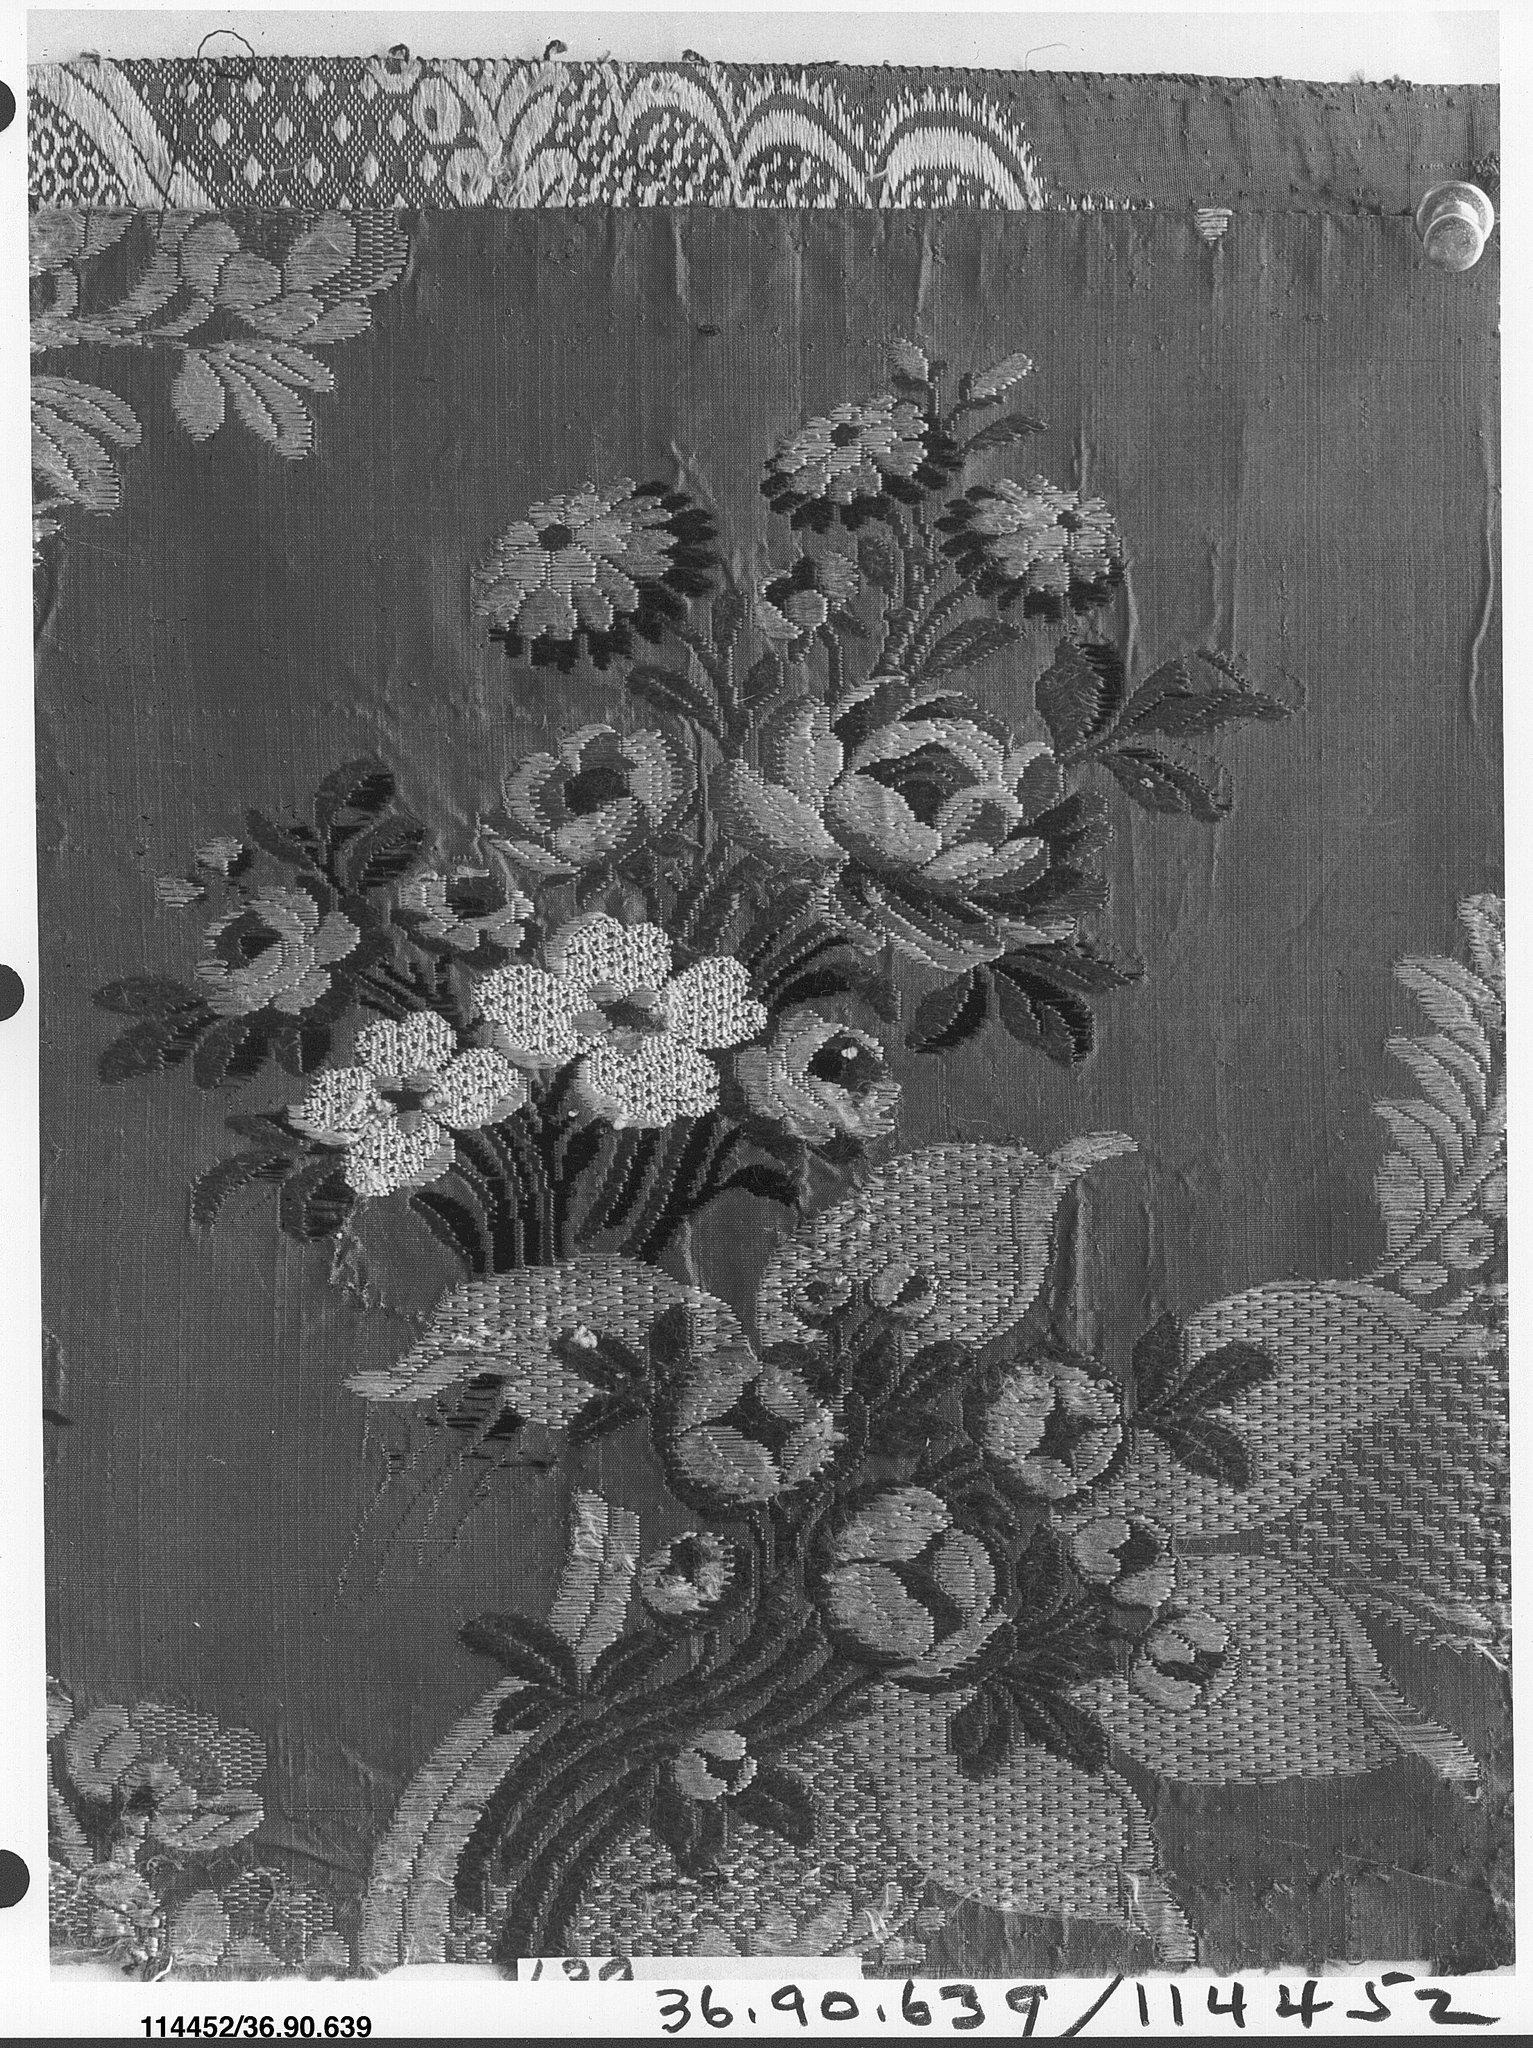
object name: piece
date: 1750-1760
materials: silk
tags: flowers